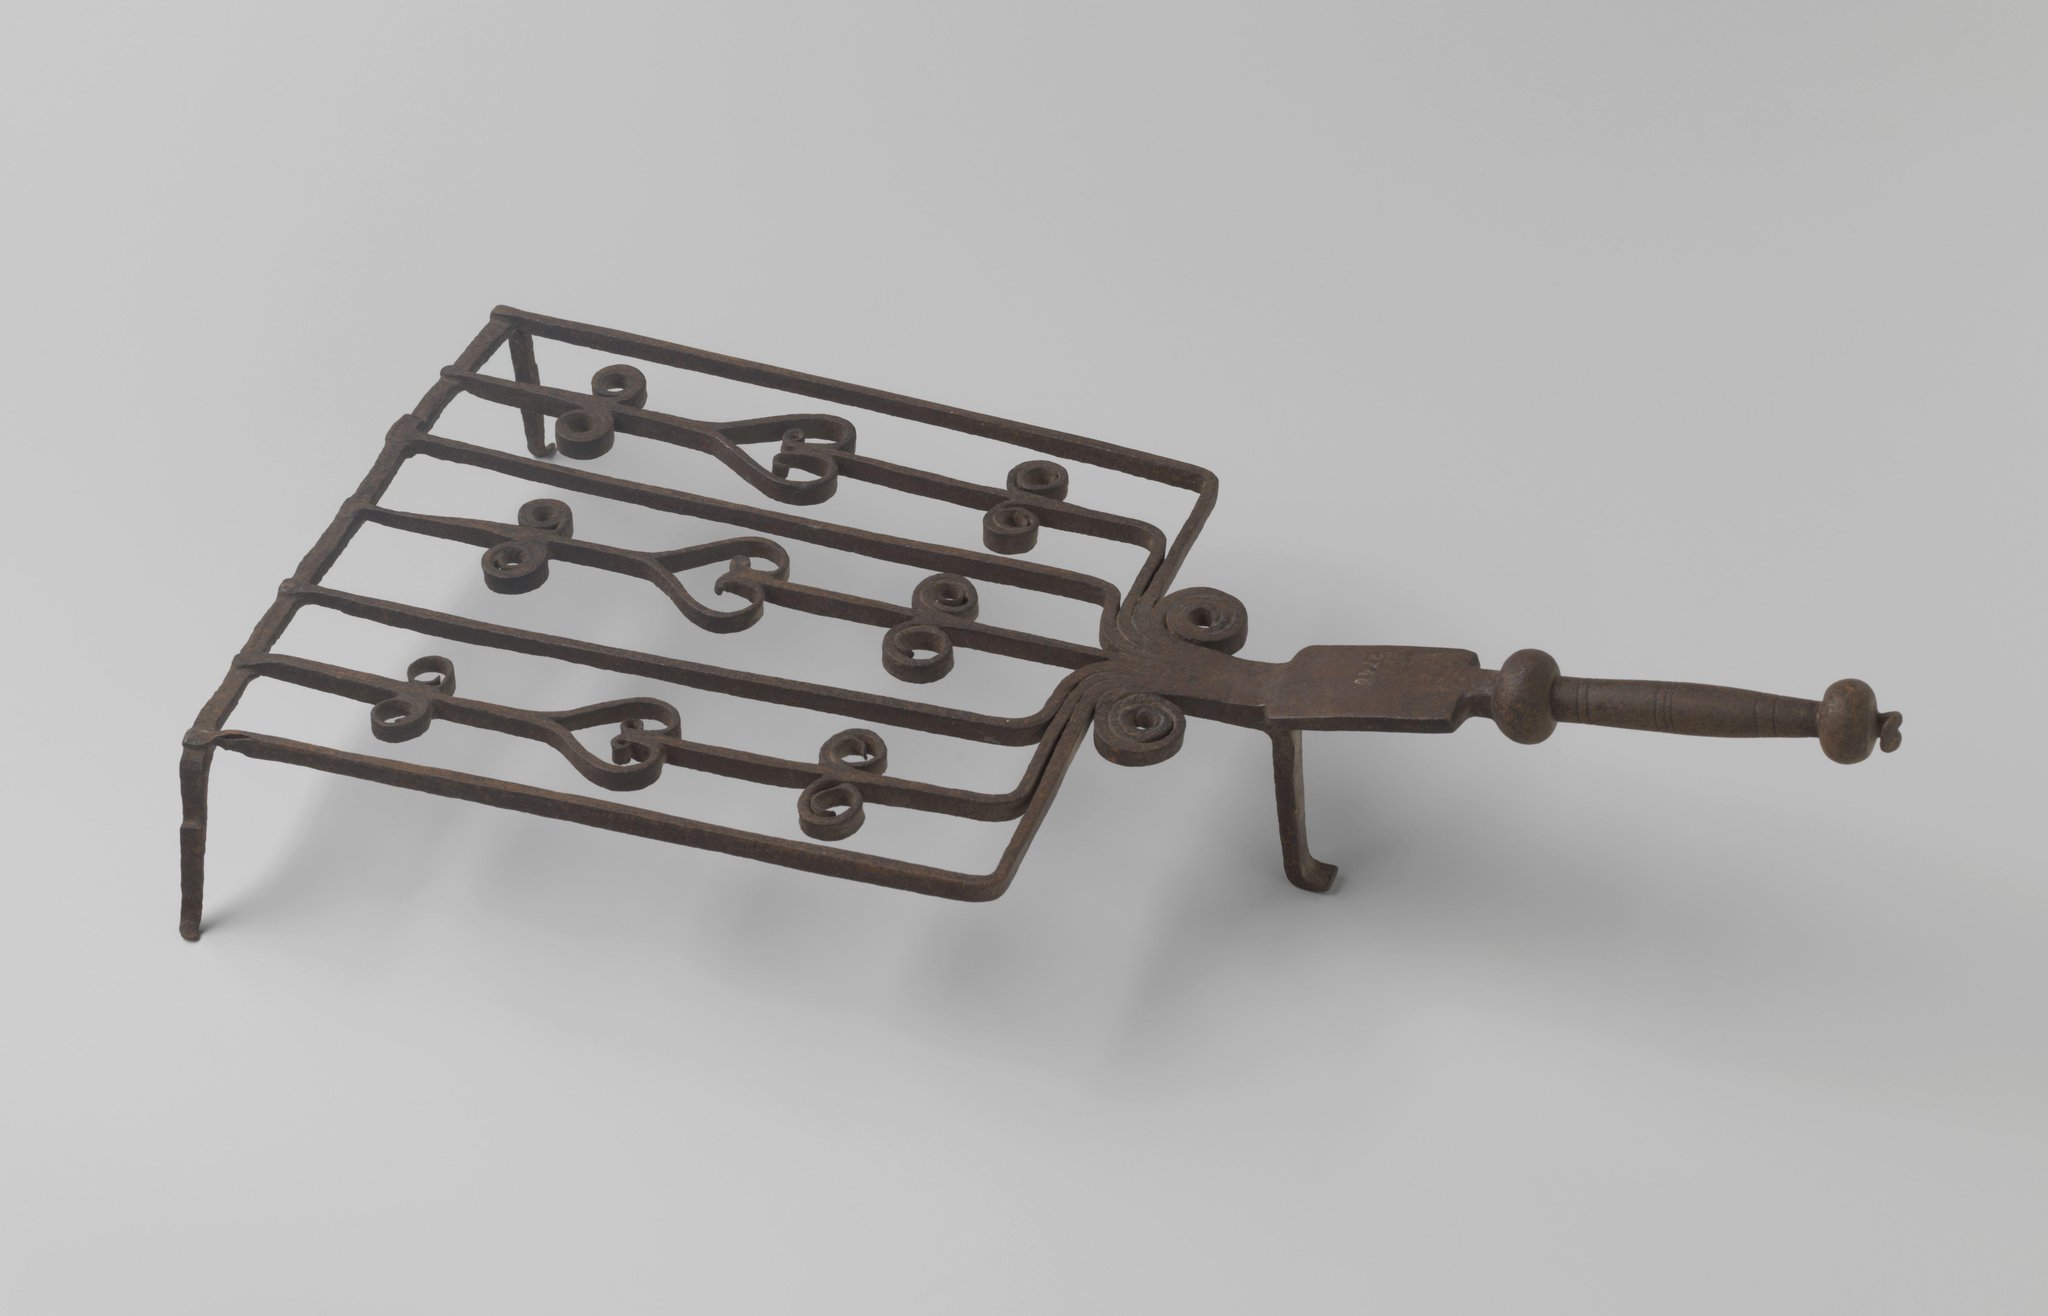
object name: rooster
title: Treeft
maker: Anonymous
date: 1400-1950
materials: iron